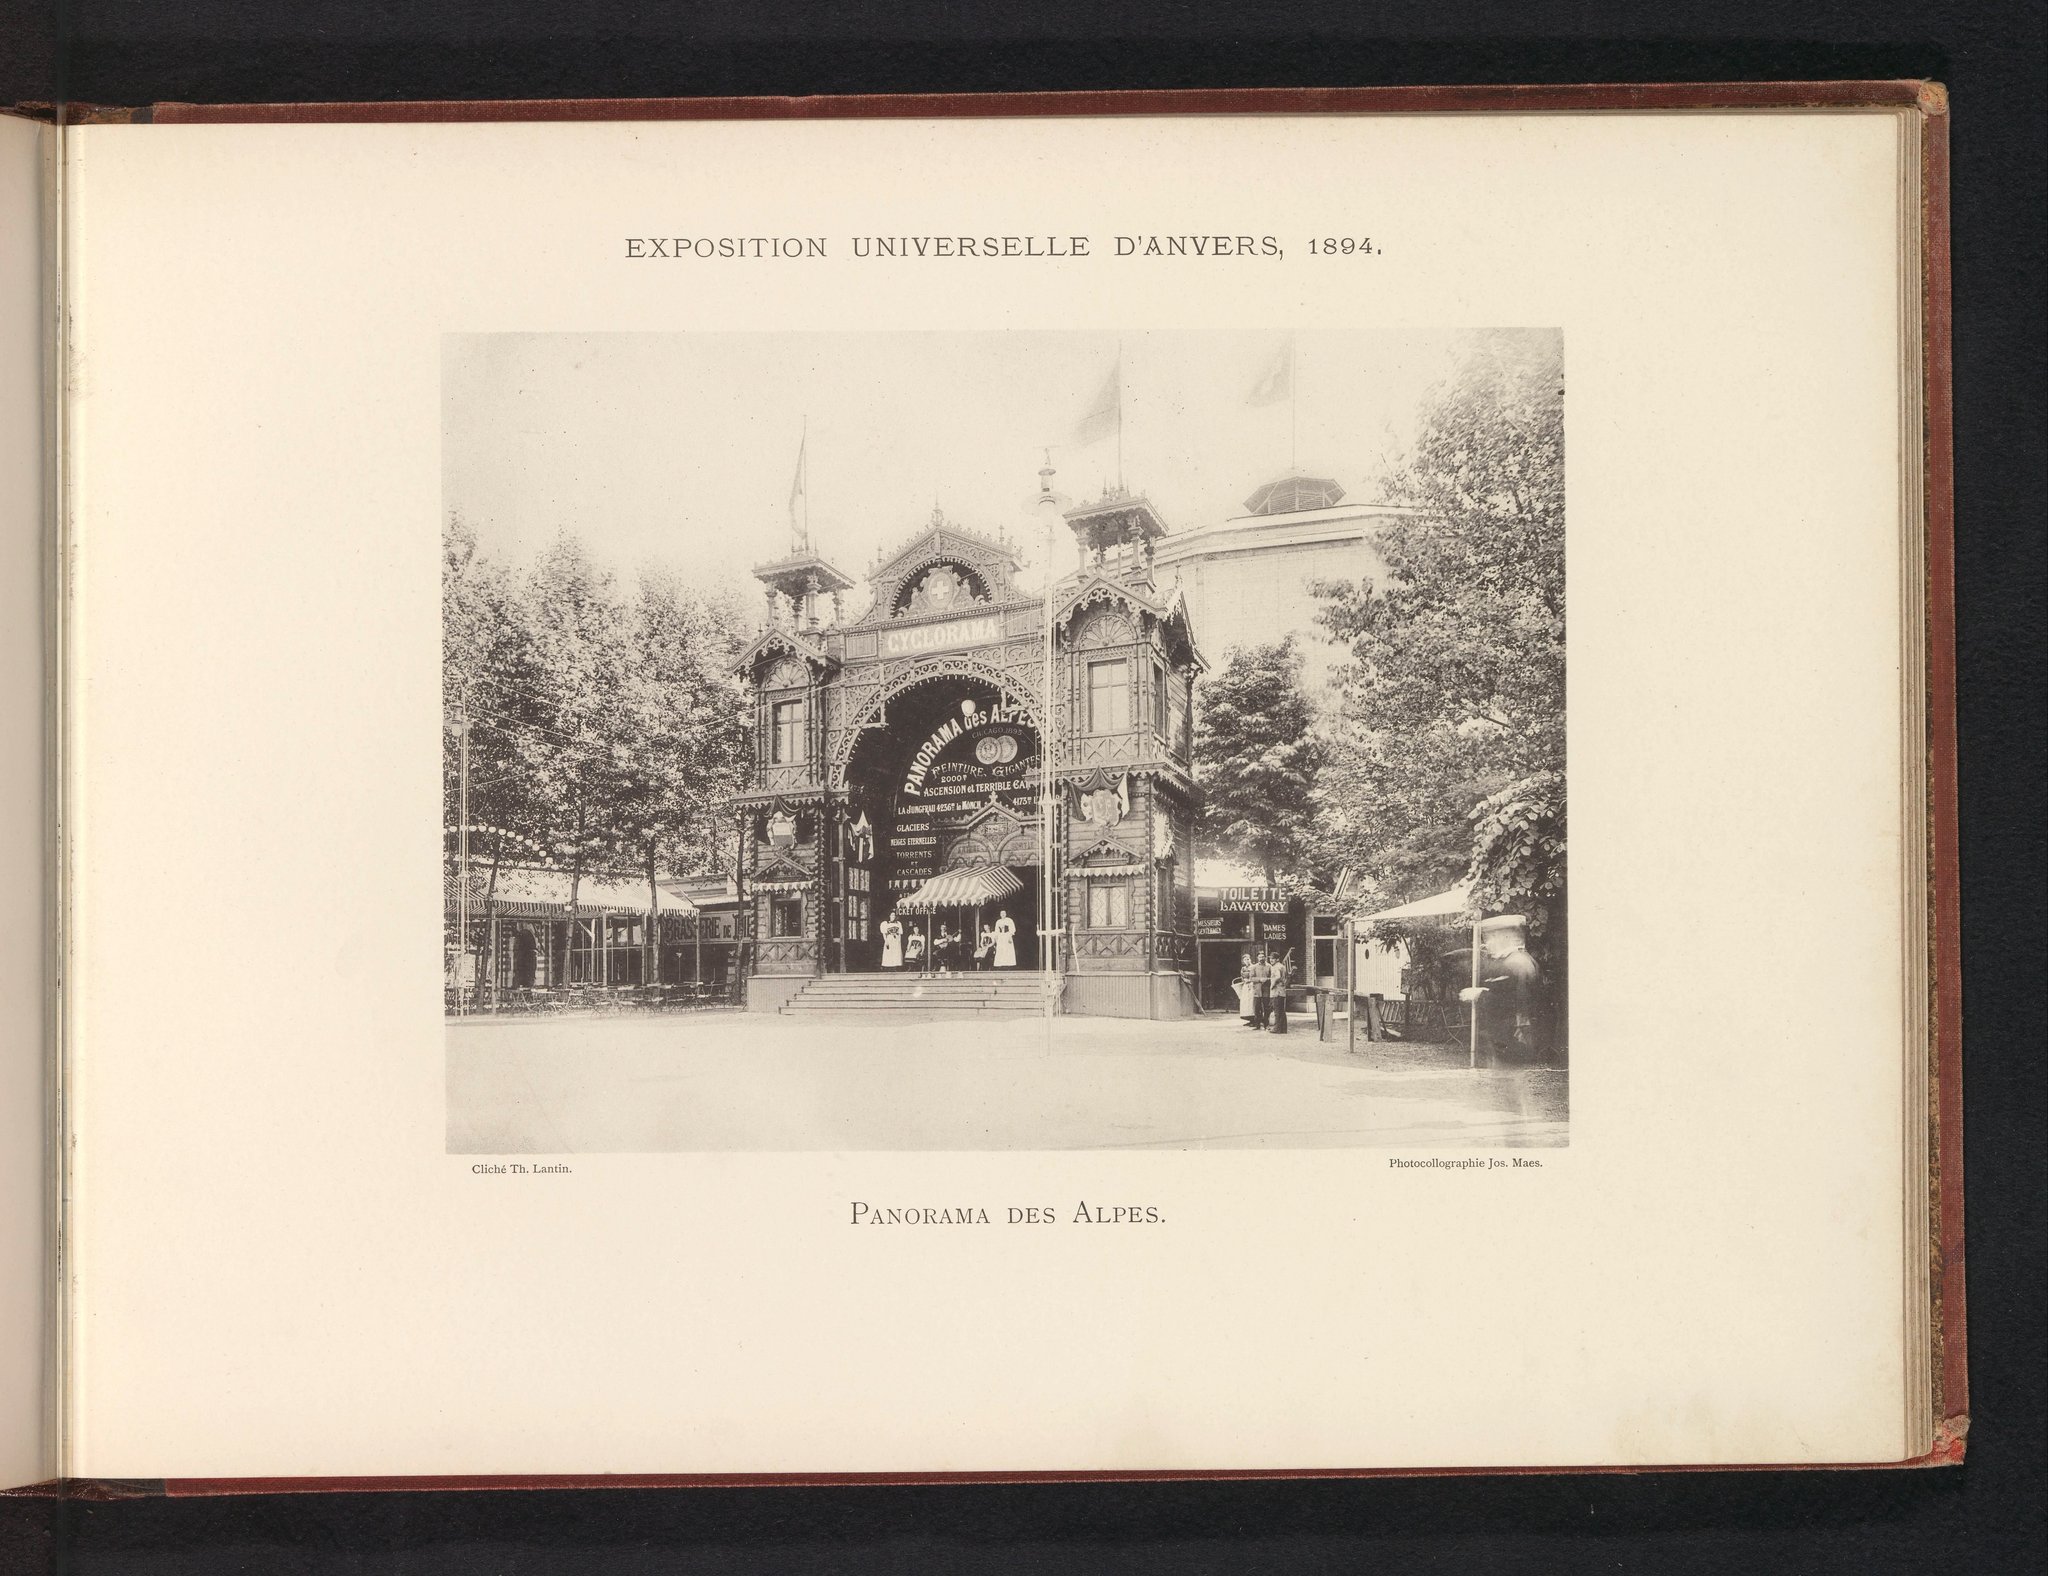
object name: page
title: Panorama des Alpes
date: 1890-1894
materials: paper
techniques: photograph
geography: antwerp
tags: world fair, world exhibition, façade (of house or building)